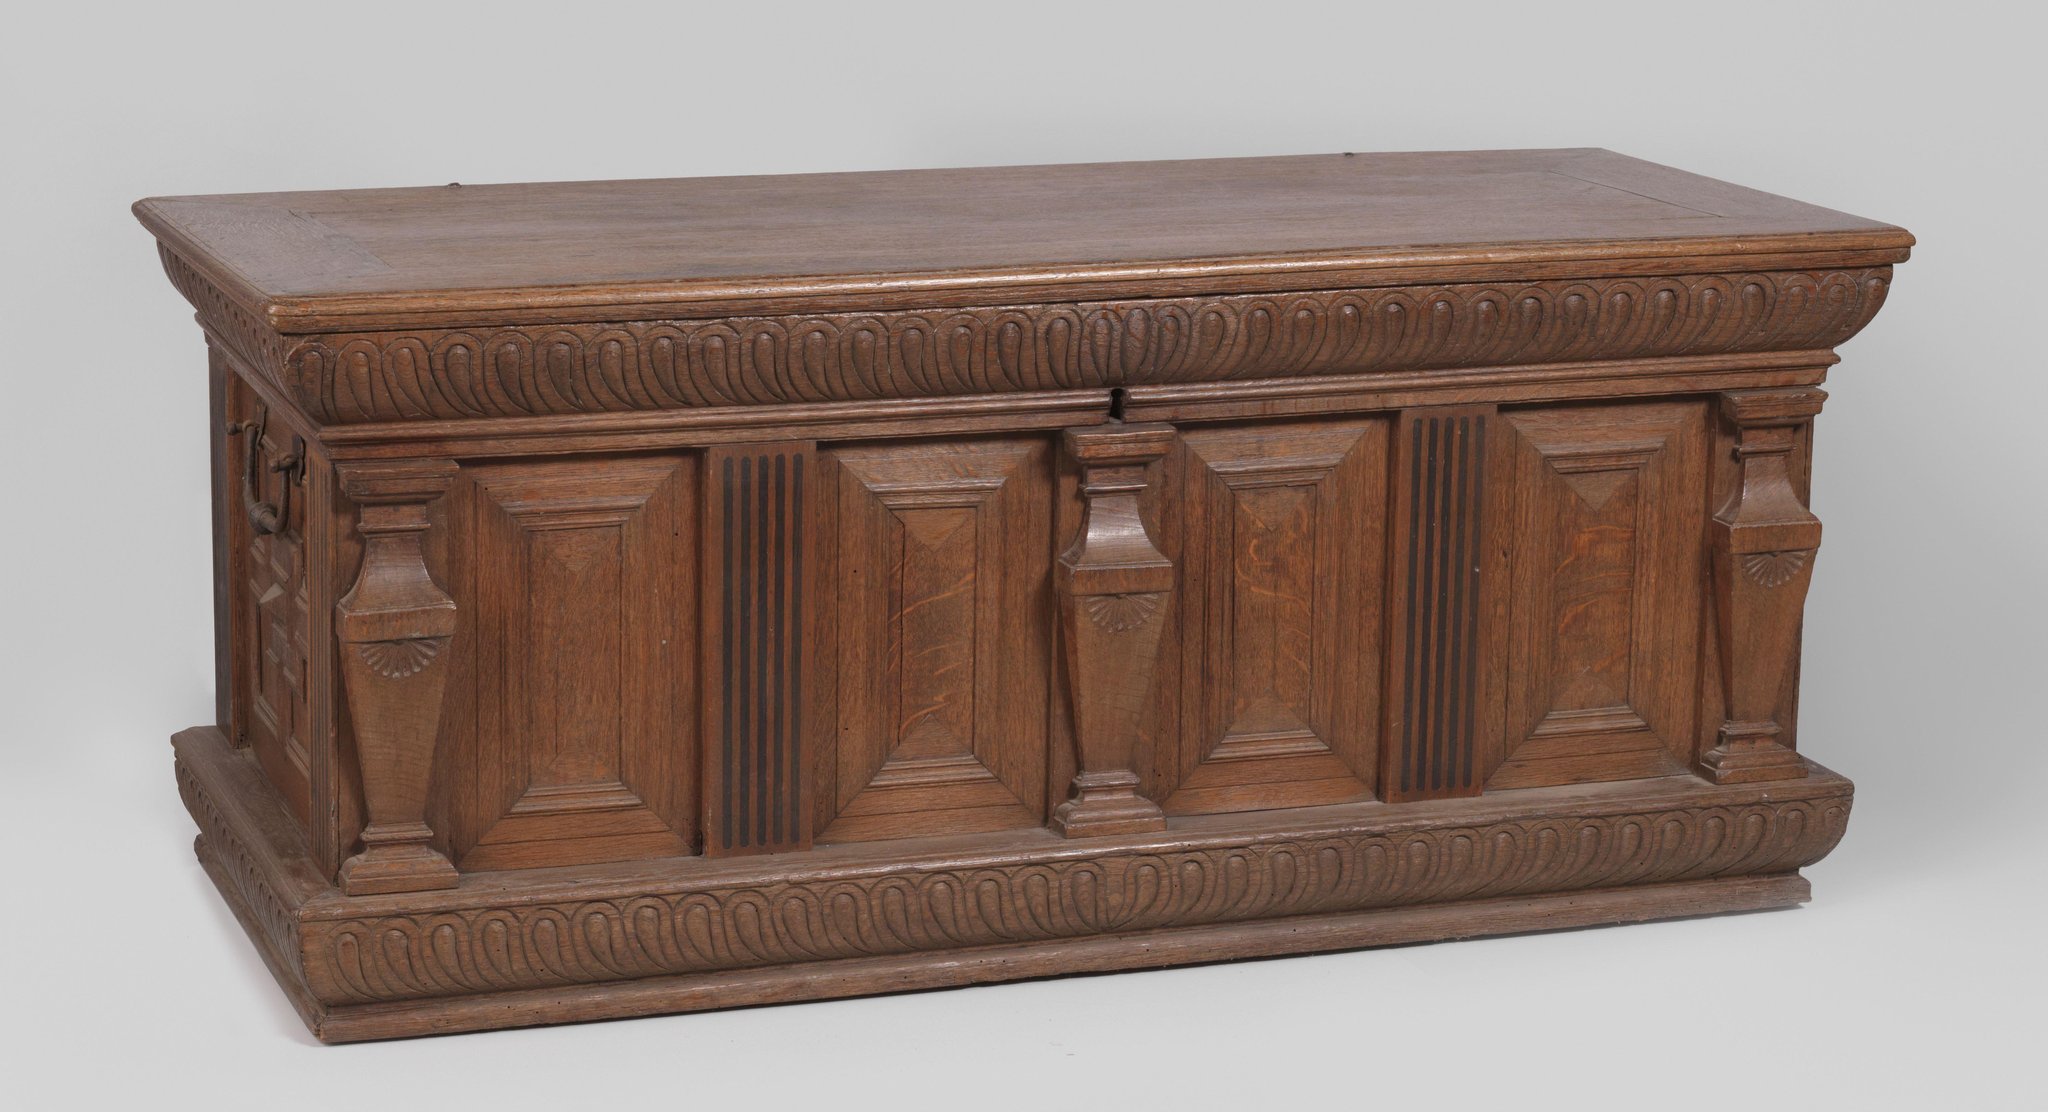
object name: case furniture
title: Meubilair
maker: Anonymous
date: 1600-1699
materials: wood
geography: northern netherlands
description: Eikenhouten kist met gebeeldhouwde ornamenten.